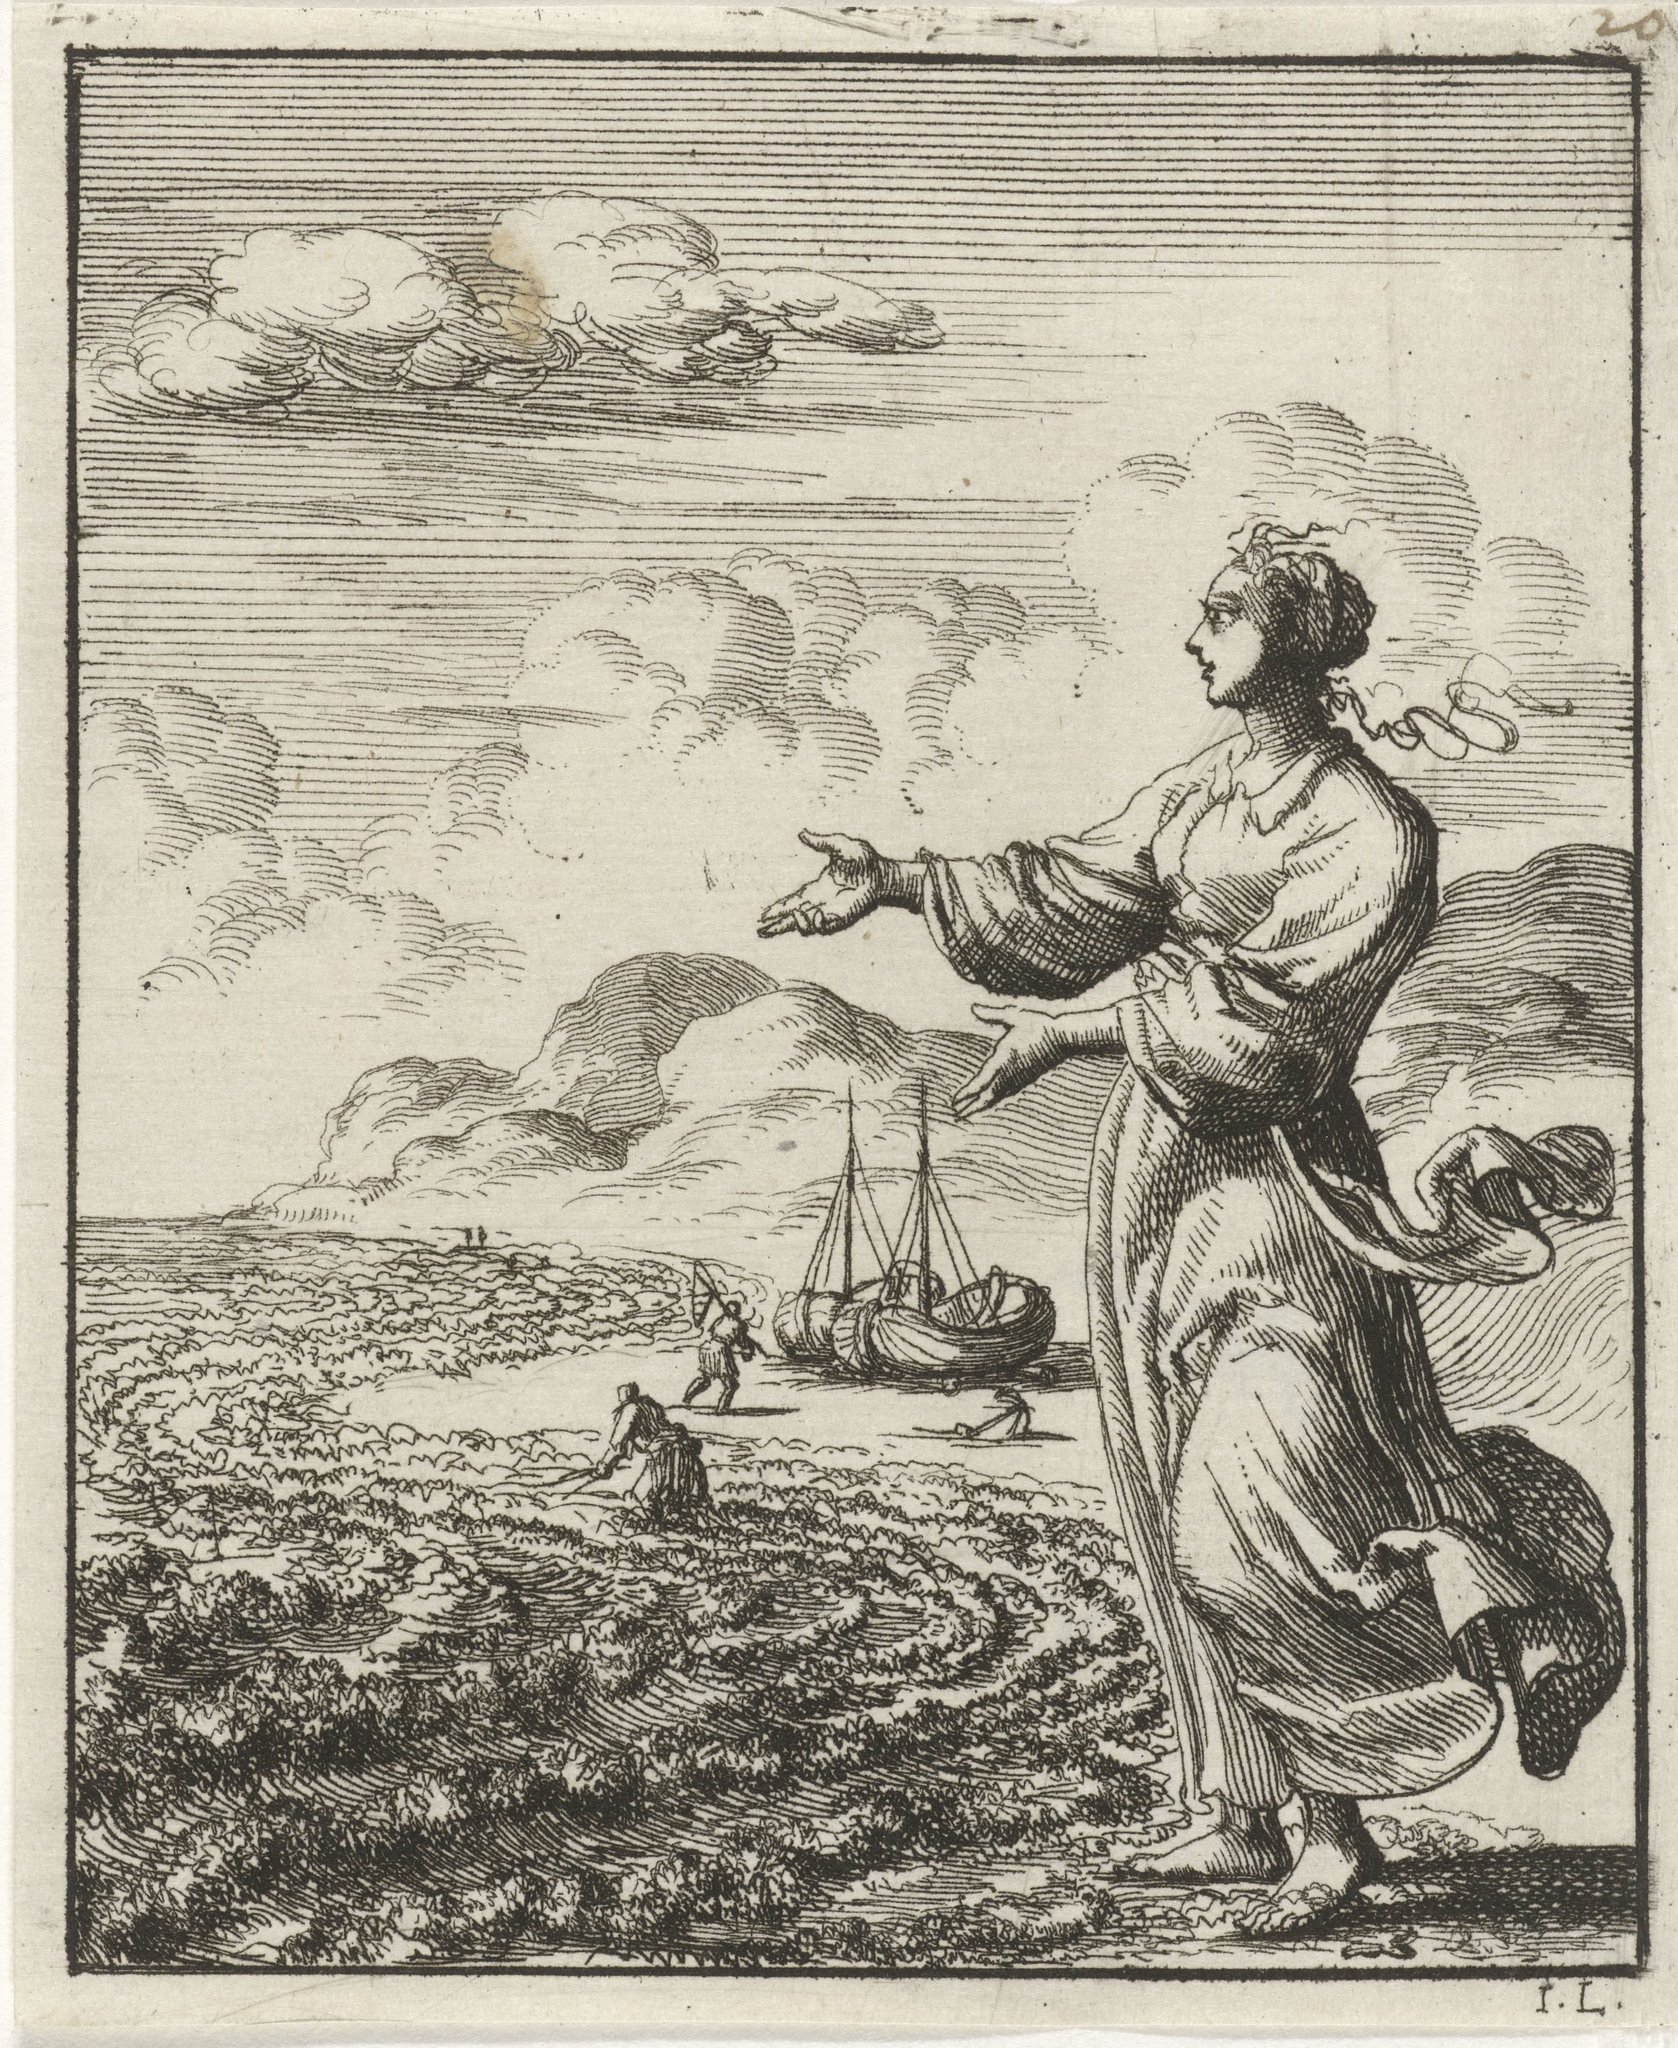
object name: print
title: Het mach geen quaad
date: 1687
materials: paper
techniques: etching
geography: amsterdam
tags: surf, breakers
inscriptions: number: ‘20’, collector's mark: Lugt 2228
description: Illustratie uit: Luyken, Jan. Voncken der liefde Jesu, van het godtbegerende zielenvier. Amsterdam: Pieter Arentsz (II), 1687, p. 80.